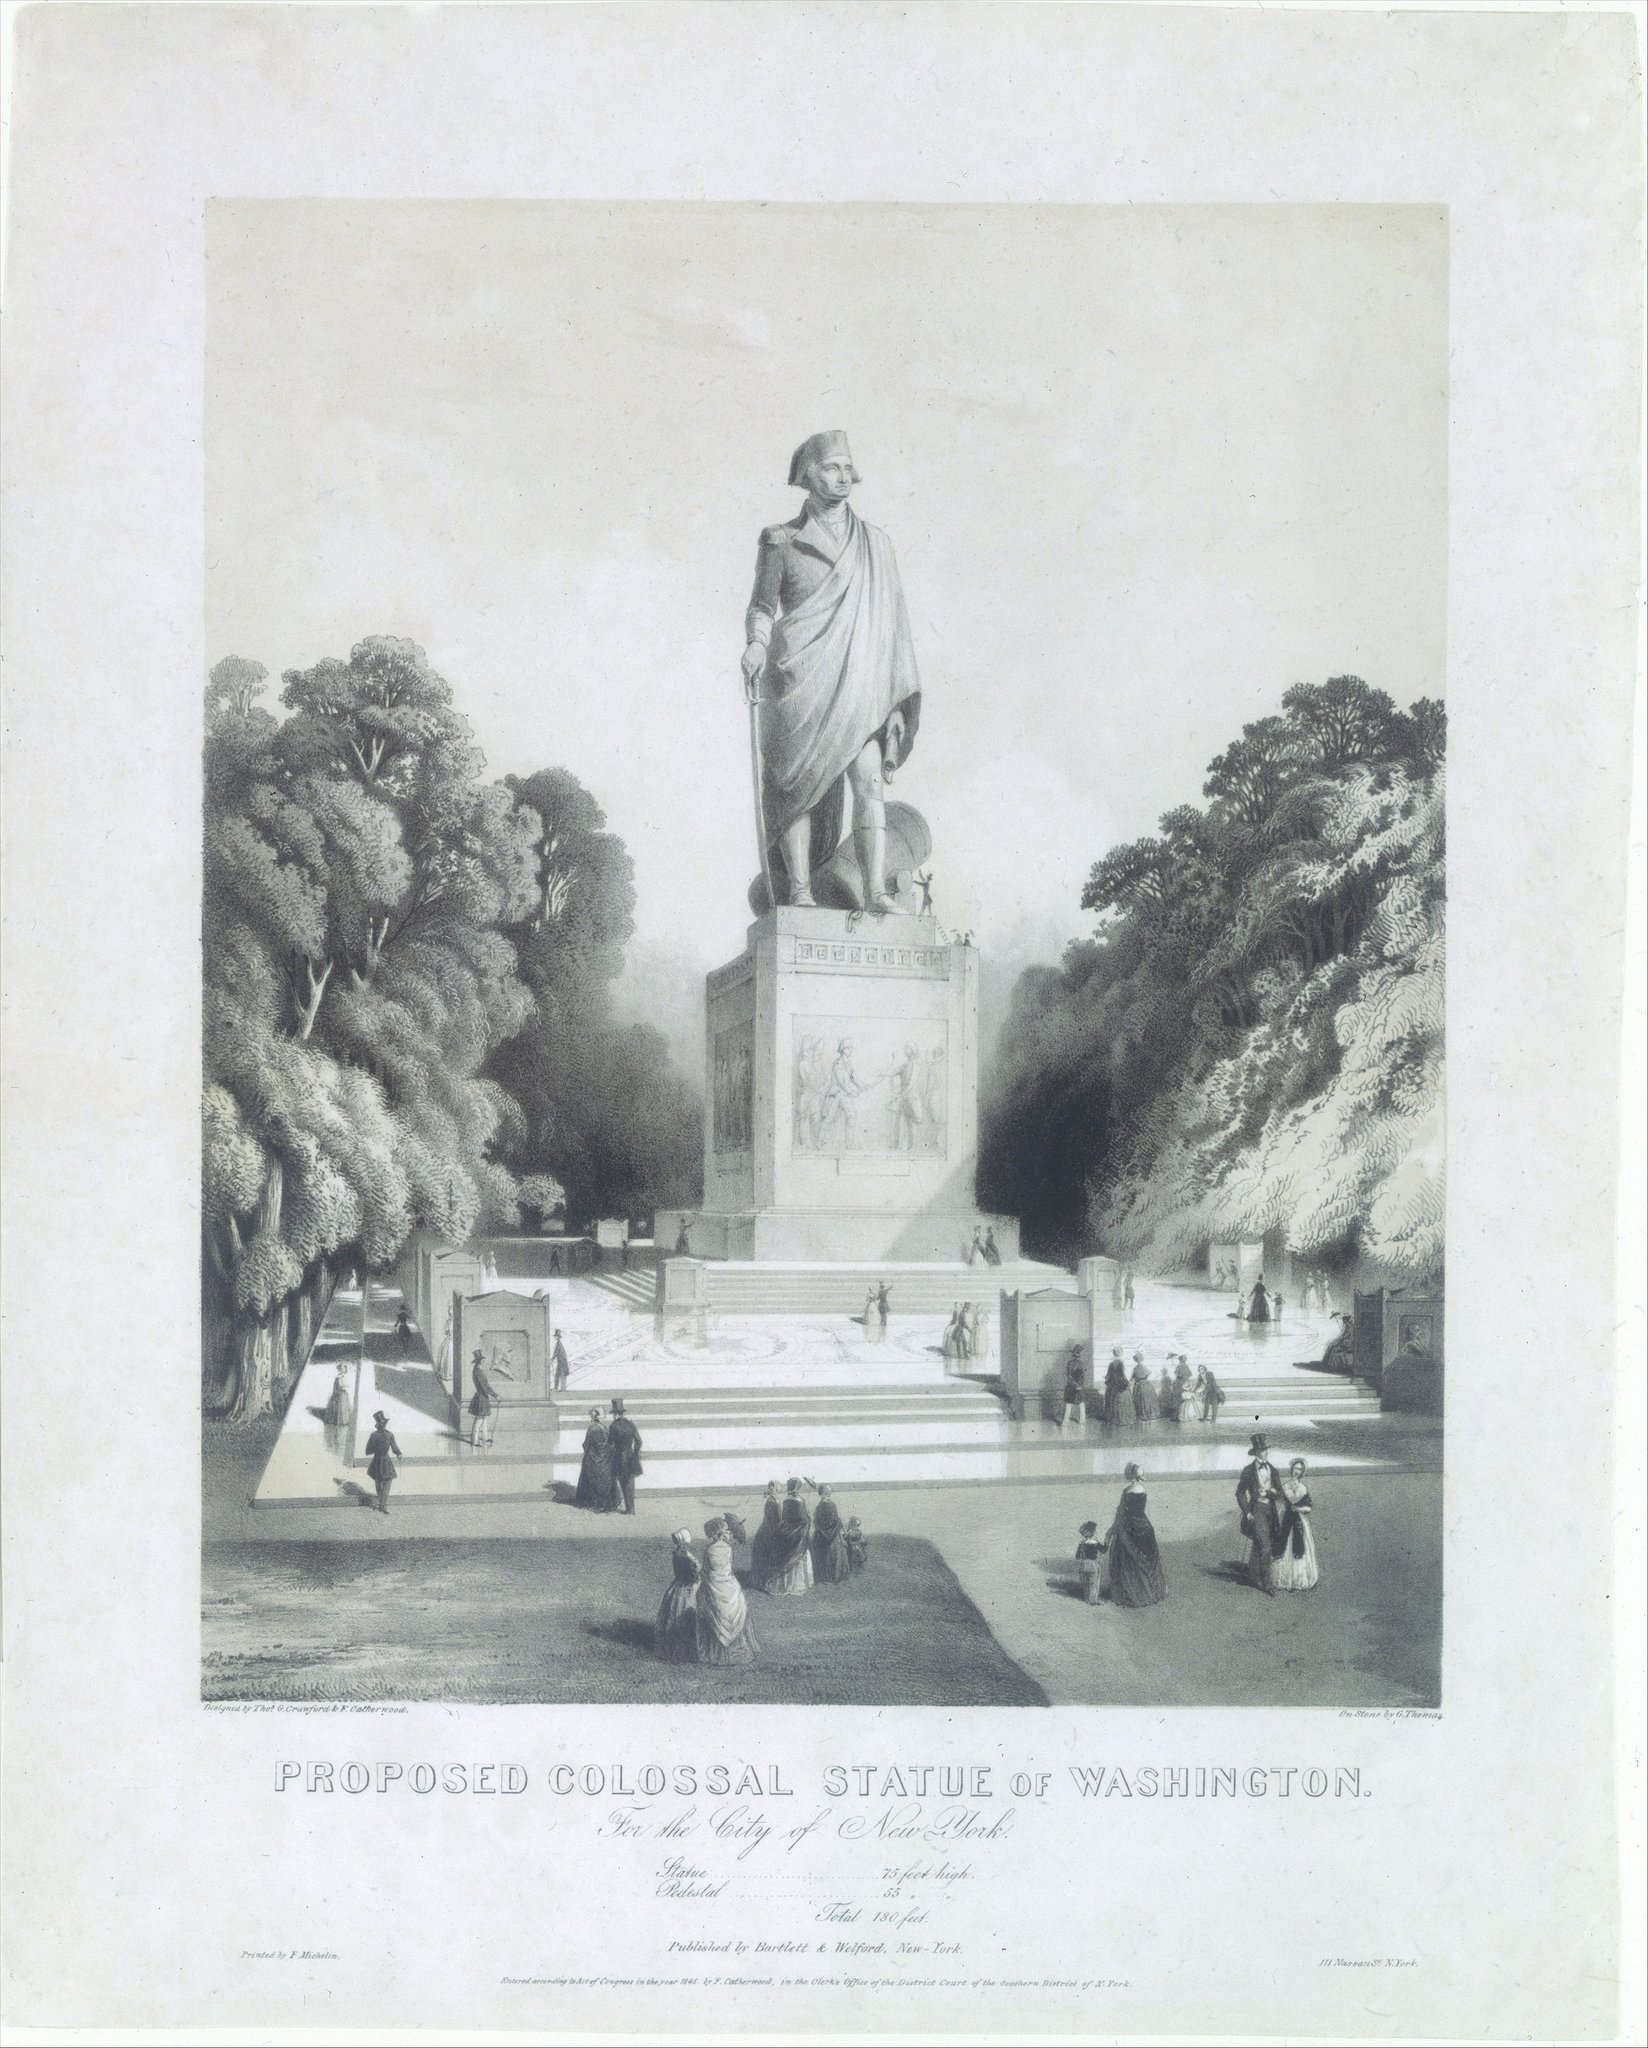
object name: print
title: Proposed Colossal Statue of George Washington for the City of New York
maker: g. thomas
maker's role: artist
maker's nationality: american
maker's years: 1800-1900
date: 1845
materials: stone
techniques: lithograph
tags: human figures,sculpture,george washington,trees